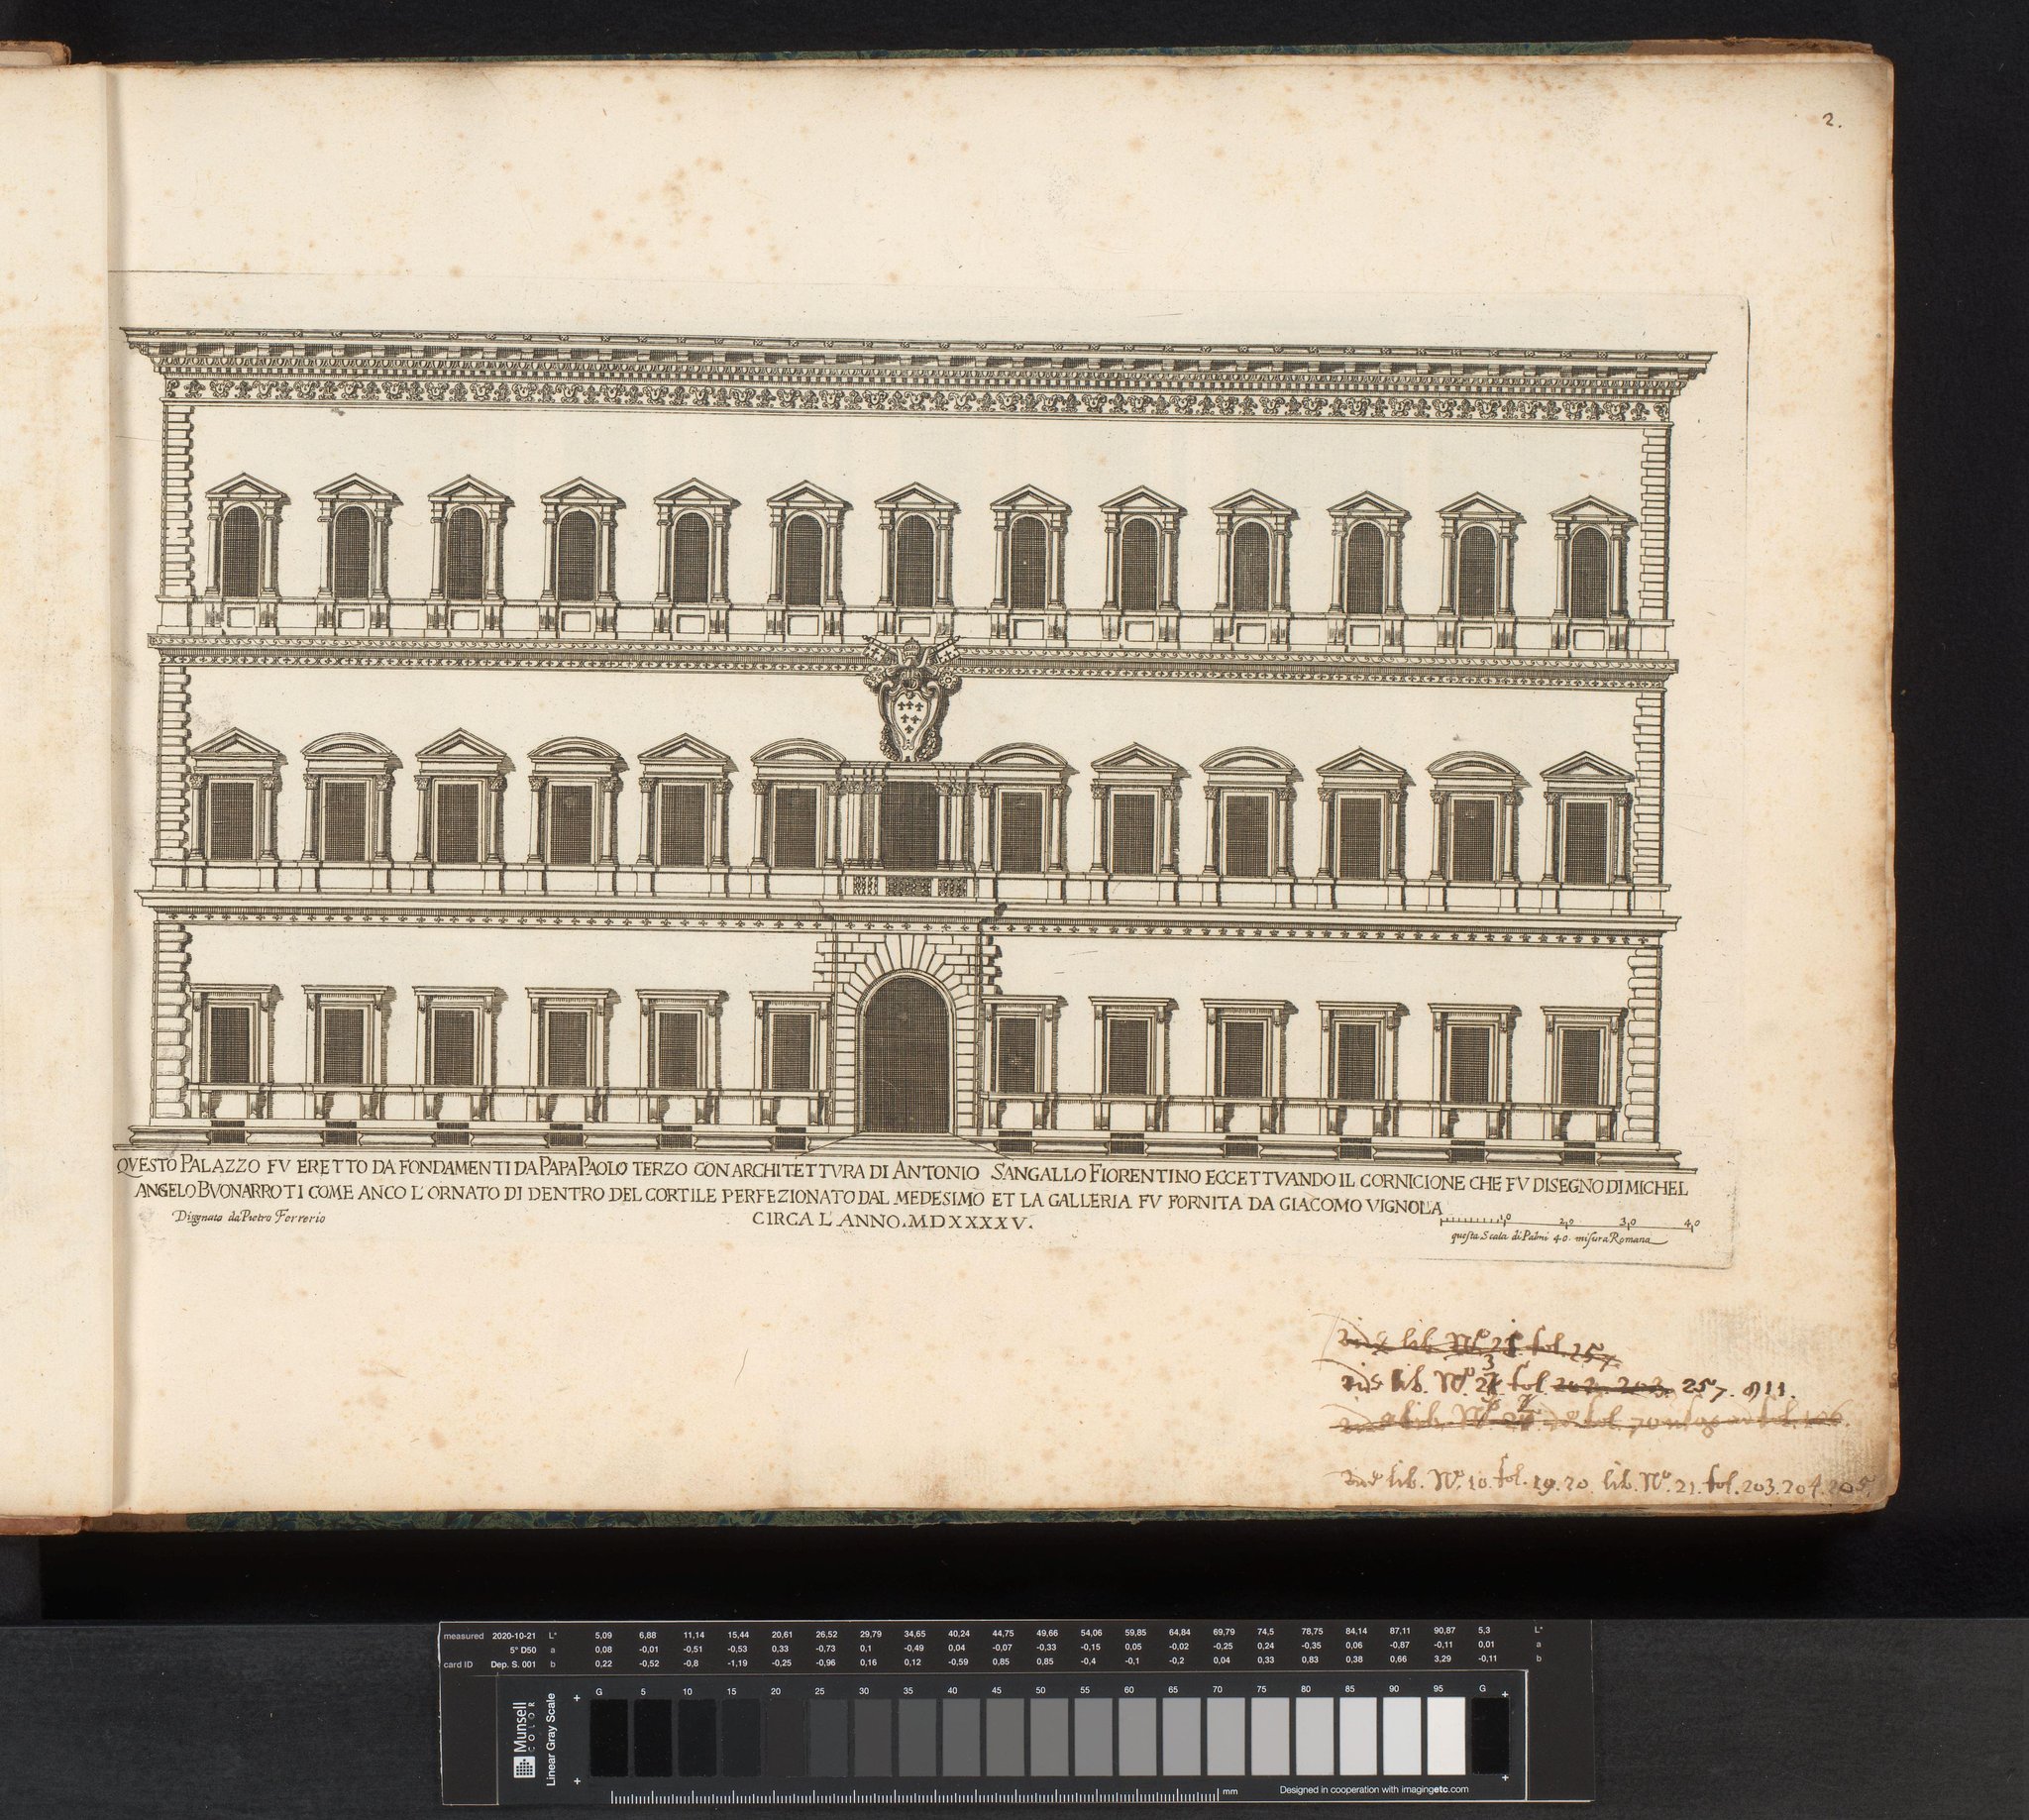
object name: print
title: Palazzi di Roma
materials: paper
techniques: etching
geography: rome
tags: palace, façade (of house or building), inner court of palace or 'hôtel'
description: Deze prent maakt deel uit van de reeks getiteld: Palazzi di Roma. Deze reeks bestaat uit twee boeken. Boek één getiteld: Palazzi di Roma dei più celebri architetti..., bestaat uit 44 prenten die worden toegeschreven aan Giovanni Battista Falda (naam staat enkel op prent 27) en uitgegeven door Giovanni Giacomo de'Rossi. Deze 44 prenten zijn bekend in twee staten (met en zonder nummer). Boek twee getiteld: Nuovi disegni dell'architetture... libro secondo, bevat 66 prenten door Giovanni Battista Falda en Simone Felice. Deze 66 prenten zijn bekend in twee staten (met en zonder nummer).